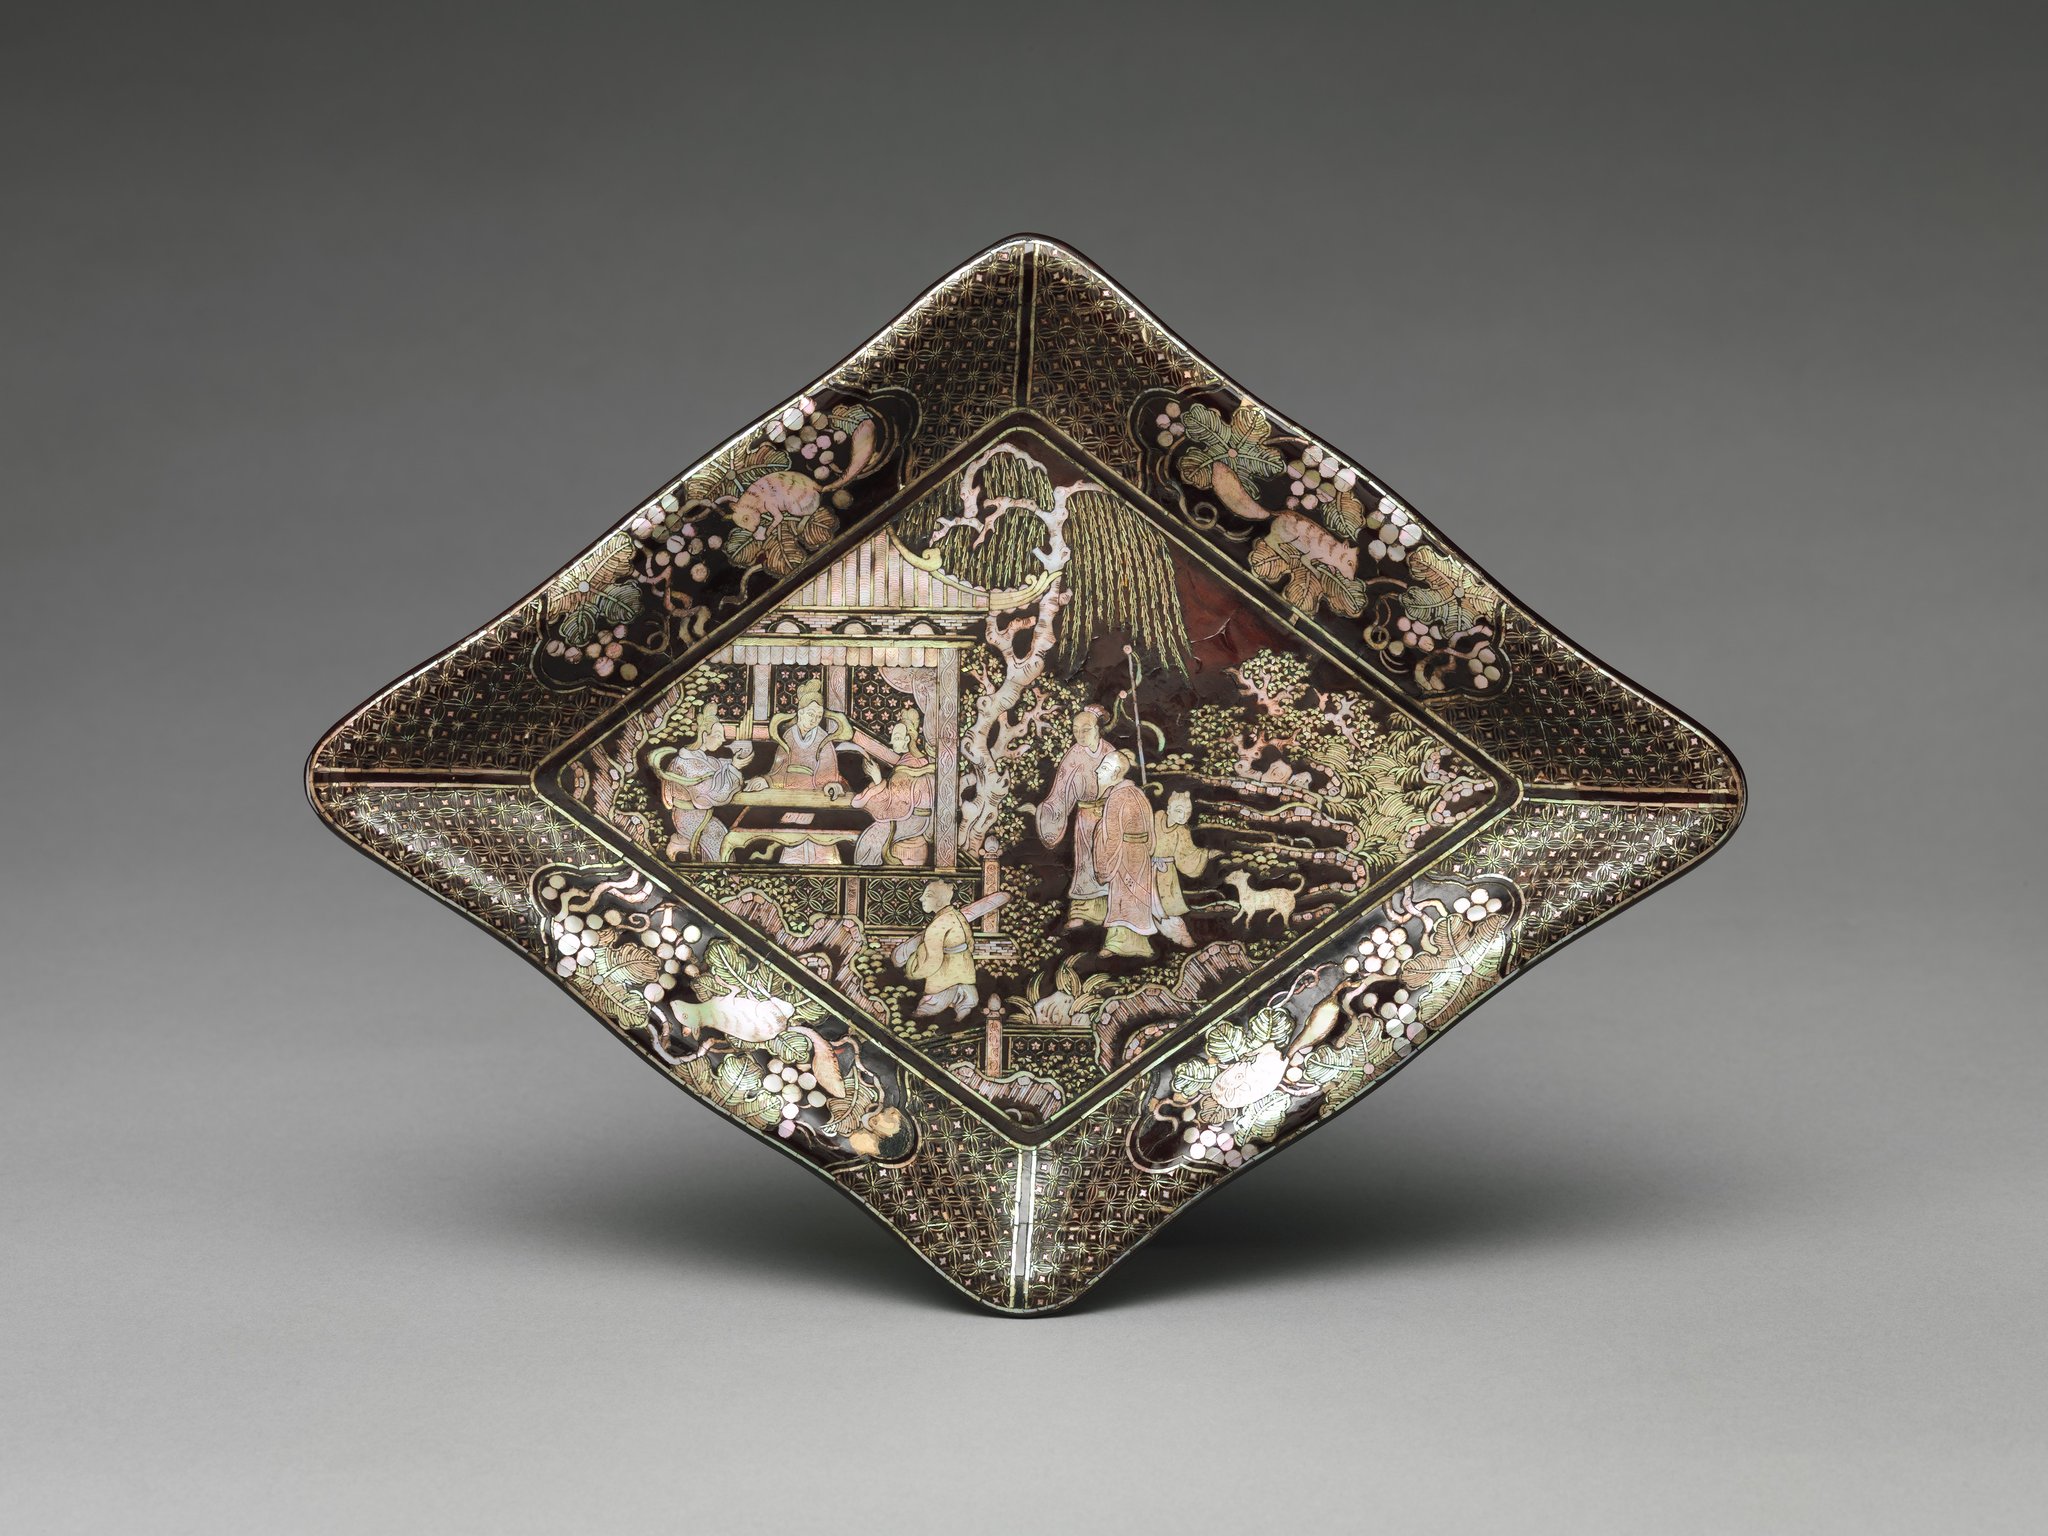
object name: dish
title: Lozenge-Shaped Dish with Garden Scene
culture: chinese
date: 1567-1700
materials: foil, gold, lacquer, mother of pearl, silver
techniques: inlay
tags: human figures,trees